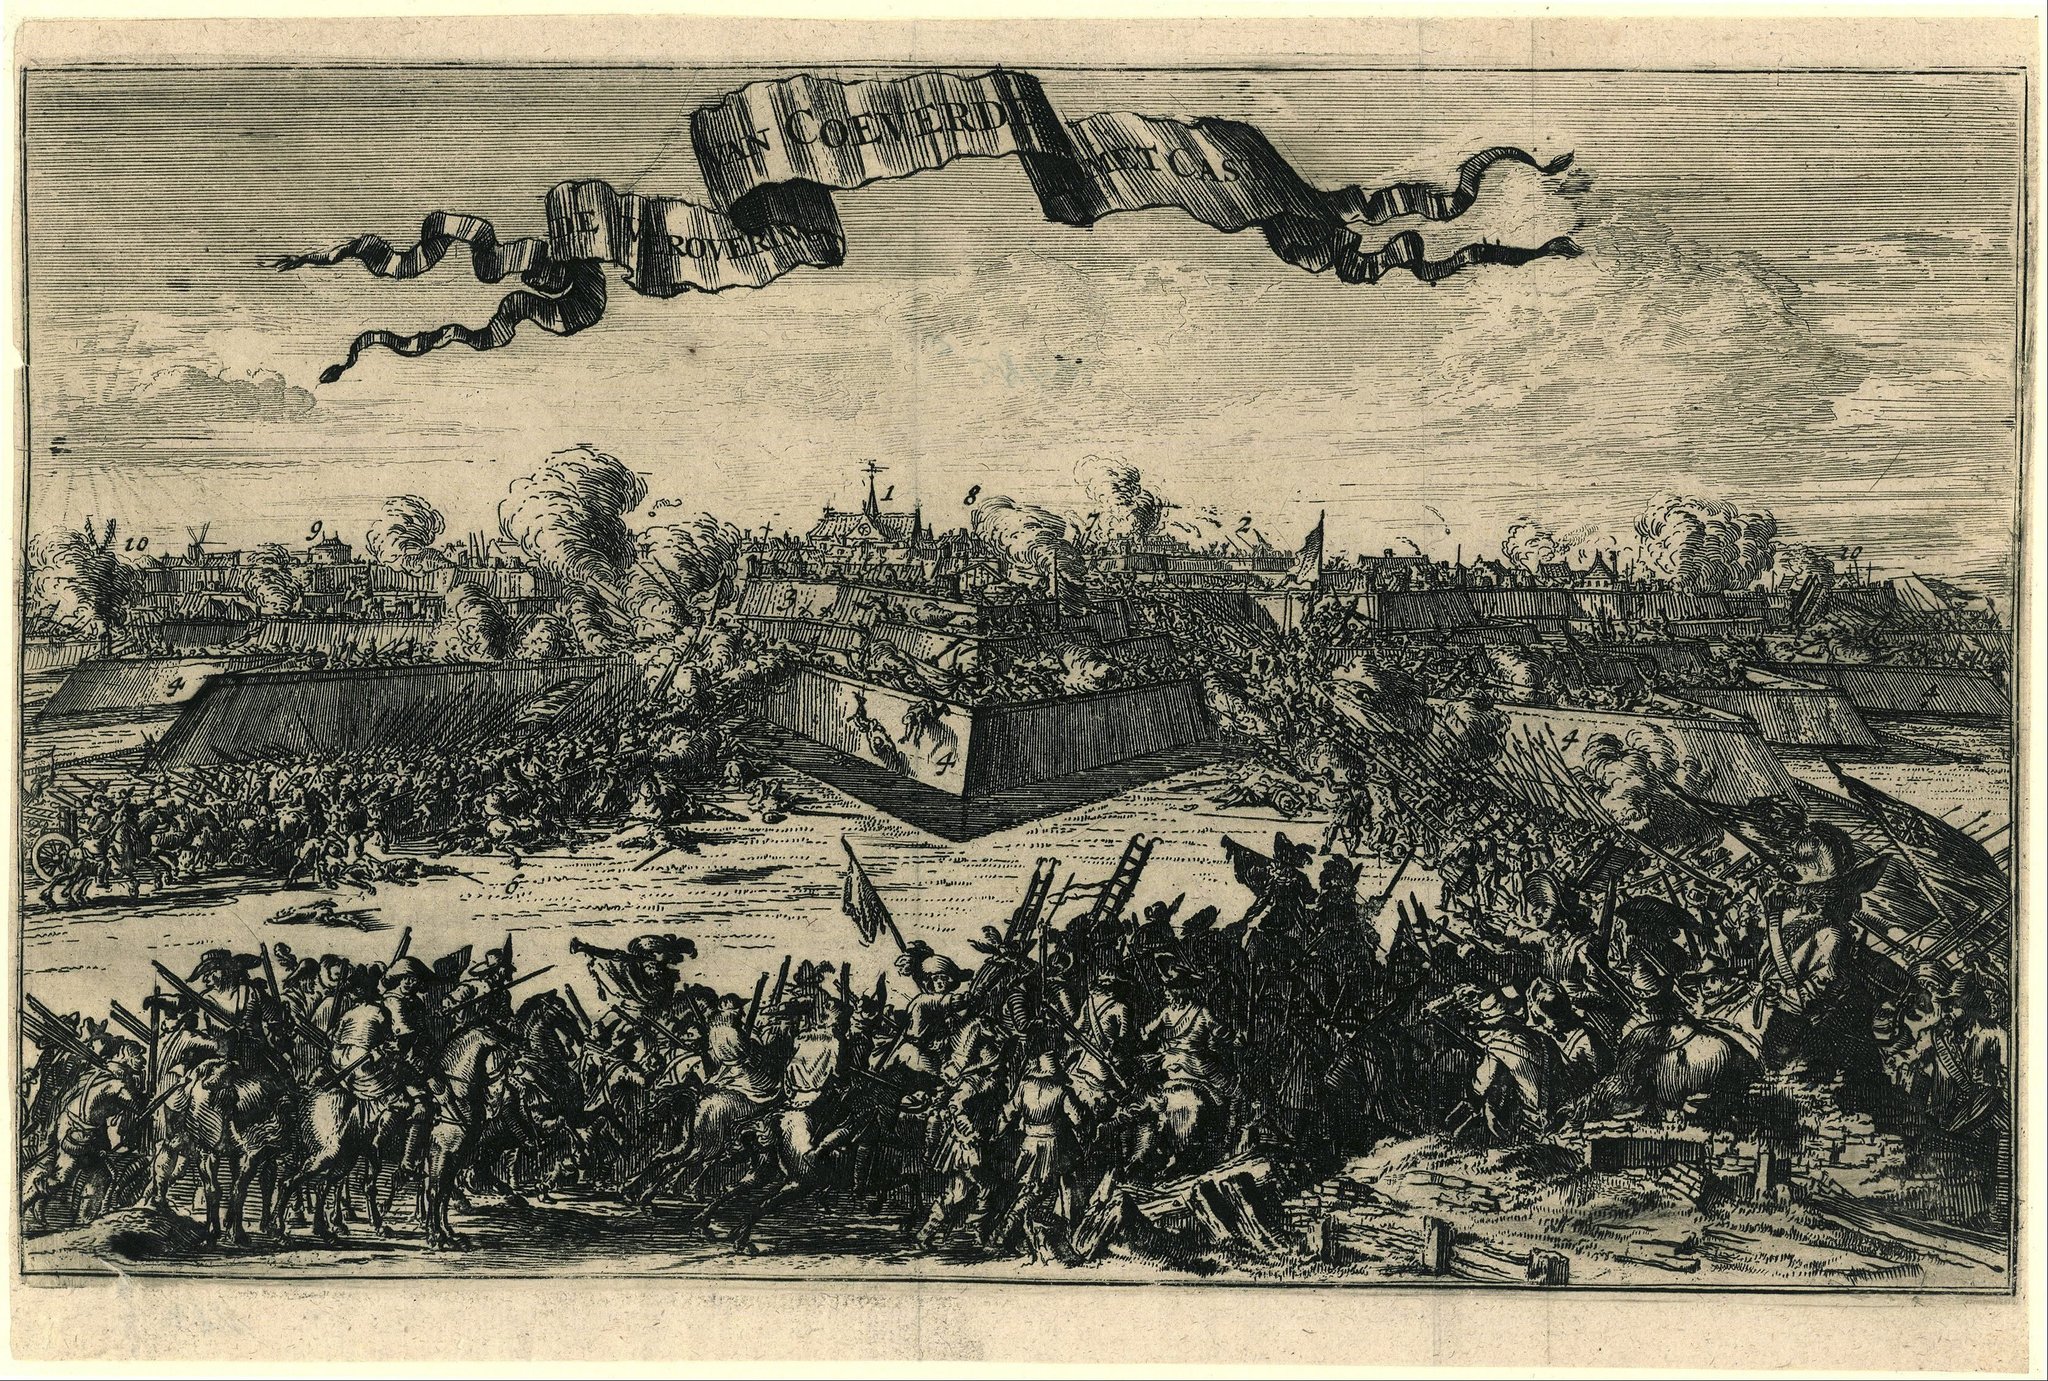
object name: print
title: De Verovering van Coeverde met Cast[eel]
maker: romeyn de hooghe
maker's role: draughtsman, goldsmith, painter, print maker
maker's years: 1645-1708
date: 1673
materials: paper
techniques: engraving, etching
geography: northern netherlands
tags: capture of city (after the siege)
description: Voorstelling van de verovering van Coevorden op 30 december 1672 door de troepen onder leiding van Karl Rabenhaupt op de troepen van de bisschop van Munster. Latere afdruk van de opgewerkte plaat toegeschreven aan Romeyn de Hooghe (FMH 2445a).